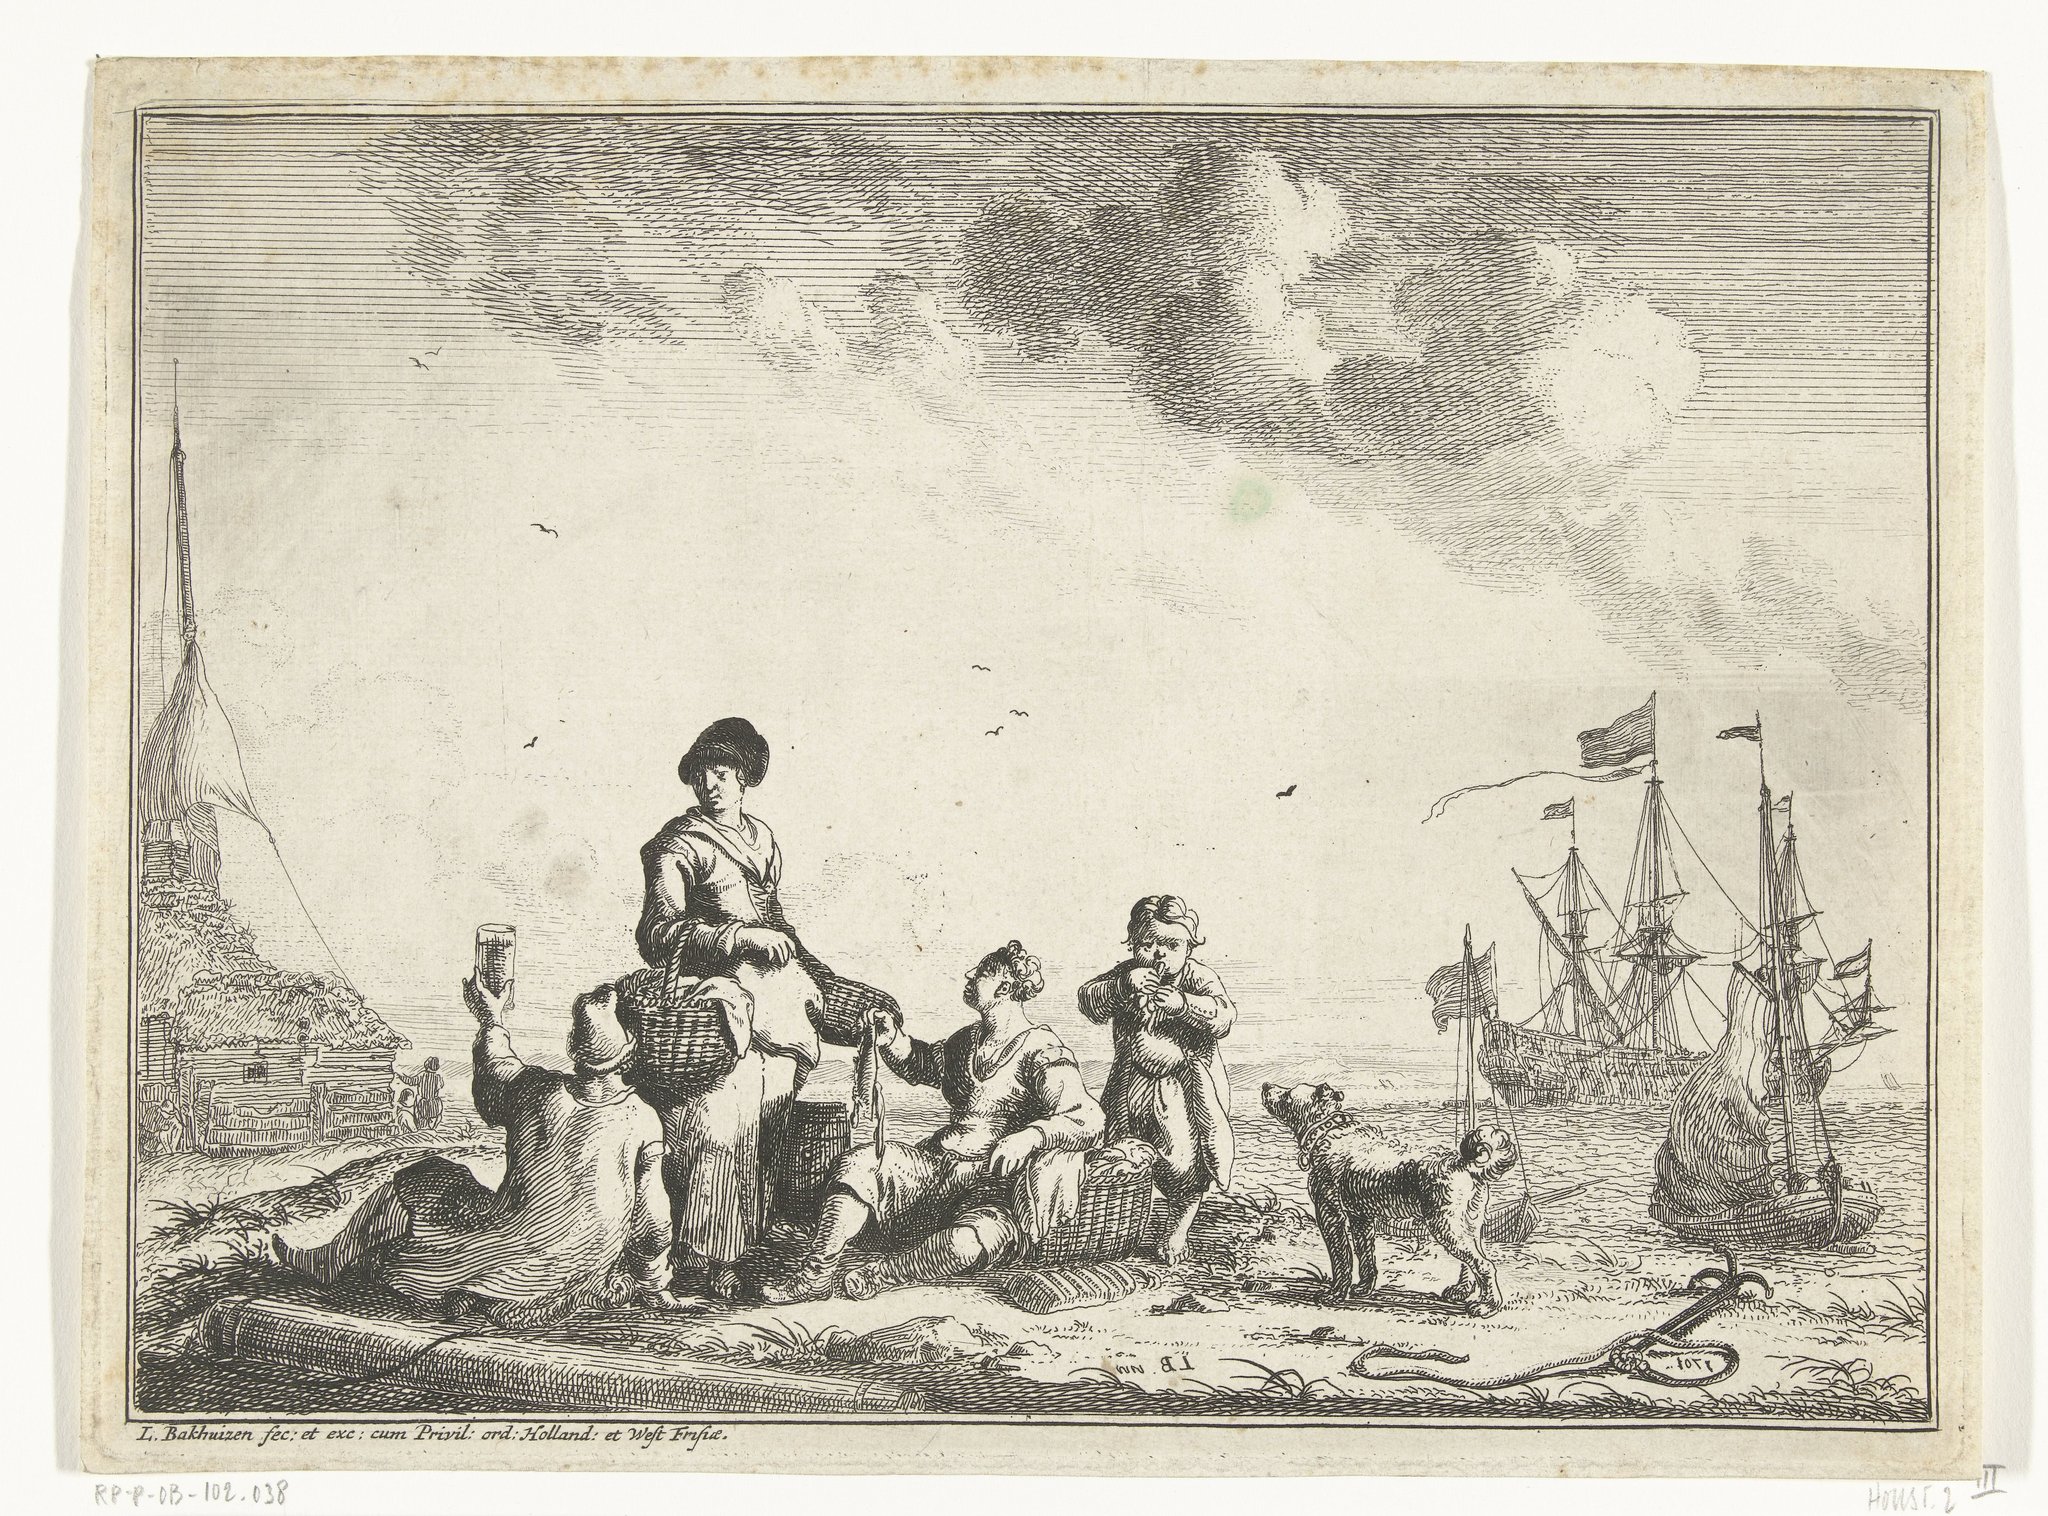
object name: print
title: Picknick aan zee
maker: ludolf bakhuysen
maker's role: draughtsman, print maker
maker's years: 1631-1708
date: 1701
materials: paper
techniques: etching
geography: amsterdam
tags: sea (seascape), picnic, alfresco, 'déjeuner sur l'herbe'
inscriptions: date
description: Een gezelschap bestaande uit een vrouw, twee mannen, een kind en een hond picknicken aan zee. Tweede prent uit een serie met tien zeegezichten.